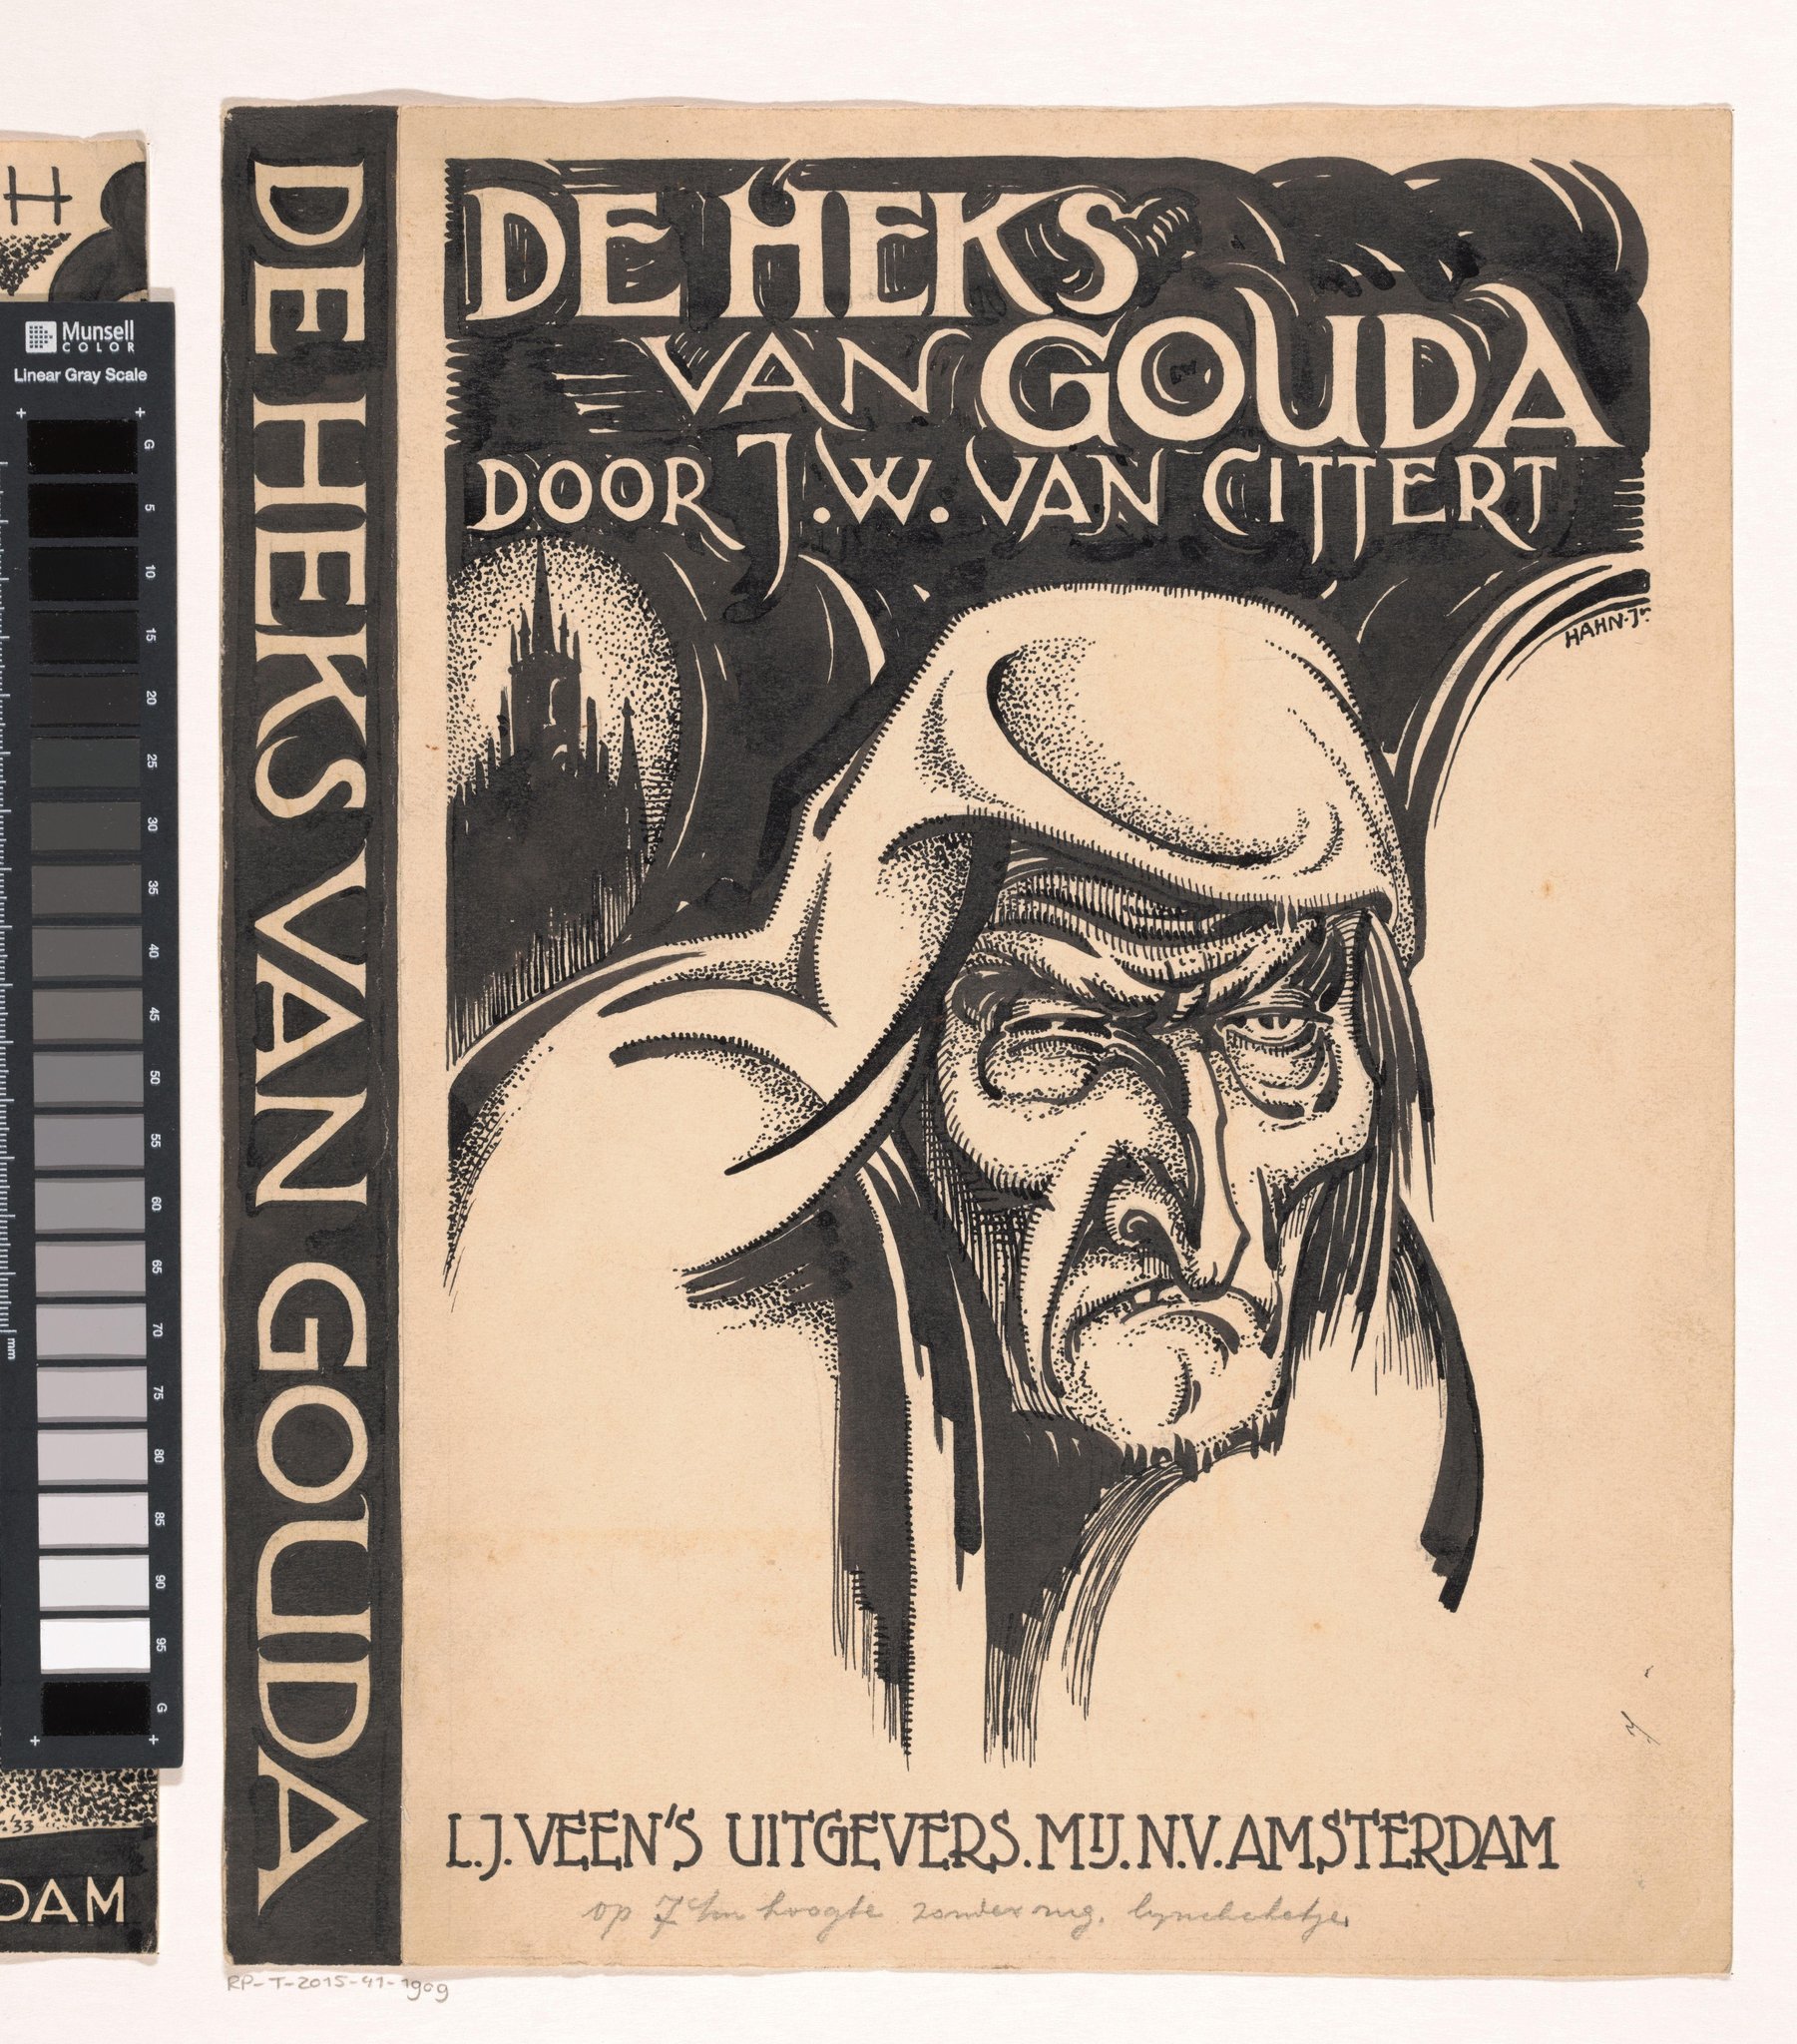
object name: study for binding design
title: Bandontwerp voor: J.W. van Cittert, De heks van Gouda. Dieuwer, jonkvrouwe van Vlist, de heks van der Goude, 1931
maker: albert hahn (ii)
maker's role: draughtsman, print maker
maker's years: 1894-1953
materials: ink, paper, pencil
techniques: brush, pen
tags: witch, sorceress, parts of church exterior and annexes: tower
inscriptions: collector's mark: Lugt 2228, :, signature: ‘HAHN.Jr.’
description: Gezicht van een oudere vrouw met een doorgroefd en neerhangend gelaat. De vrouw draagt een hoofddoek. In de achtergrond een kerktoren.